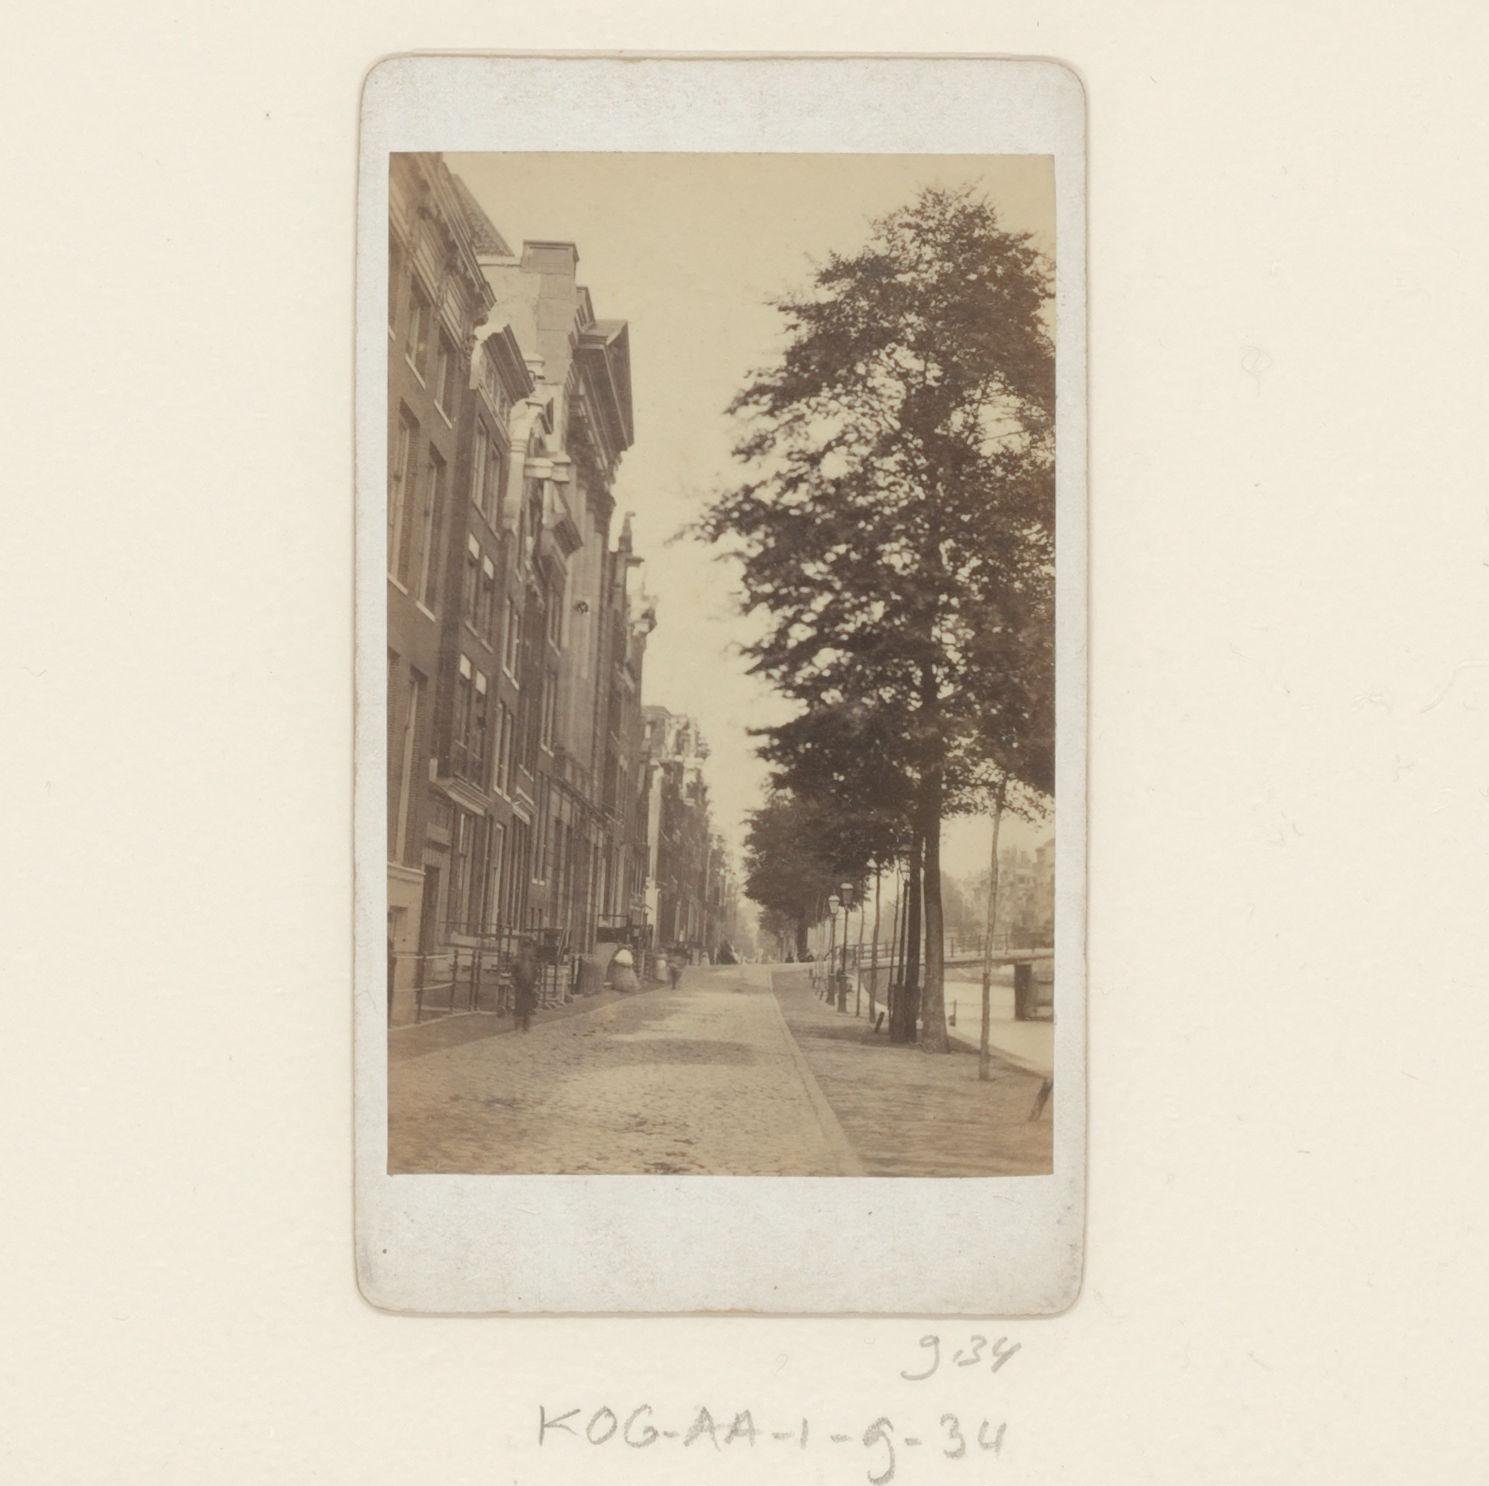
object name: carte de visite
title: Gezicht op de Keizersgracht bij de Berenstraat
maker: andries jager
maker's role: publisher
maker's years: 1825-1905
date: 1849-1885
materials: cardboard, paper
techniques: albumen print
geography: amsterdam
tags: city-view in general; 'veduta', canal, the usual house or row of houses, street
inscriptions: inscription: ‘107. De Keizersgracht (...) 110, te Amsterdam.’, collector's mark: ‘9,34’ Lugt 1641b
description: Onderwerpsrubriek binnen de Atlas Amsterdam: Kadijksplein, Karthuizerkerkhof, Kattegat, Kattenburg, Kapelsteeg O.Z., Enge Kerksteeg, Kerkstraat, Kinkerstraat, Kolk O.Z., Koningsplein, Kromboomsloot [Krom Boomssloot], Kostverlorenkade, Kwakersdwarspad, Kalverstraat, Keizersgracht (v.d. Brouwersgracht – Amstel), Klerensloot (Gedempte), Klimopstraat, Kloveniersburgwal, Kraansluis.